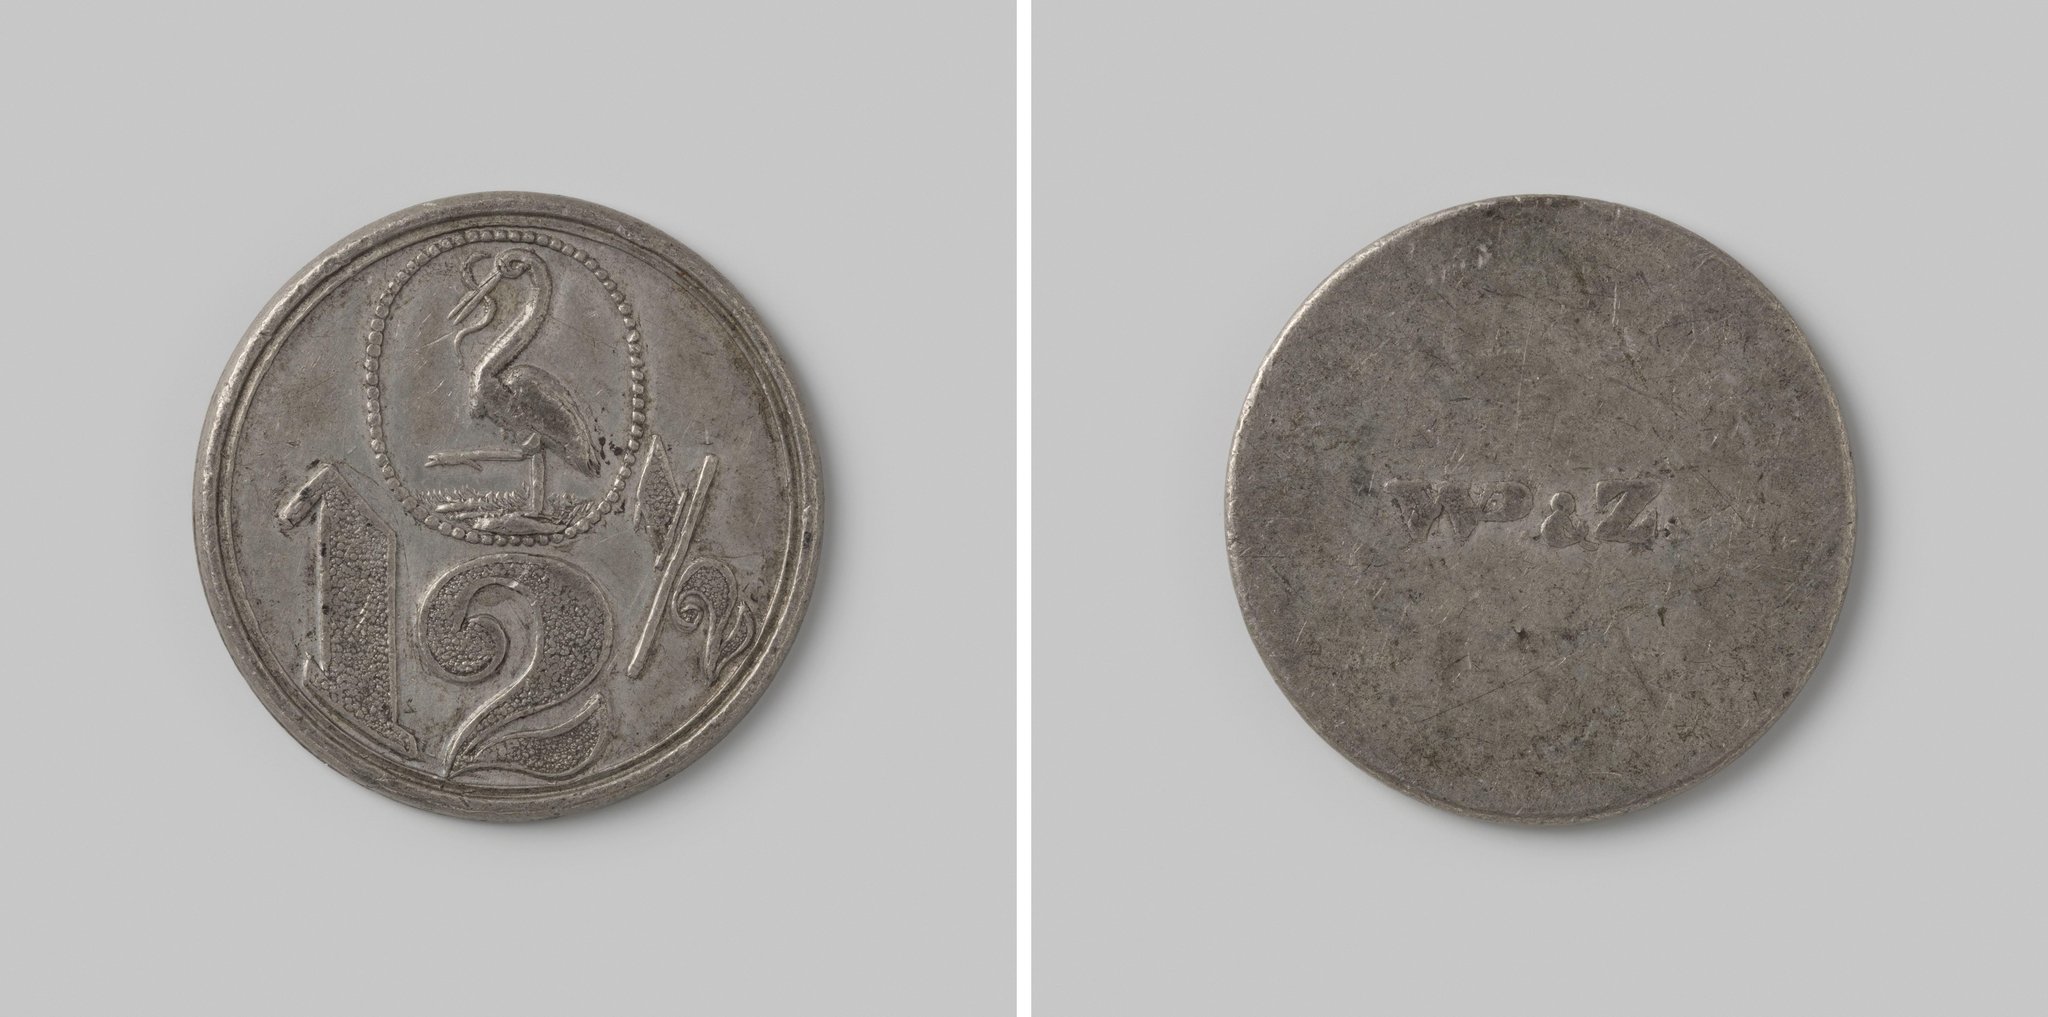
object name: history medal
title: Betaalpenning van 12½ cent uit Den Haag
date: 1900-1940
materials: metal alloy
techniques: striking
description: Koper-nikkelen penning, op de voorzijde een parelcirkel met een palingetende ooievaar boven de numerieke waarde, de keerzijde blanco met centraal een regel tekst.